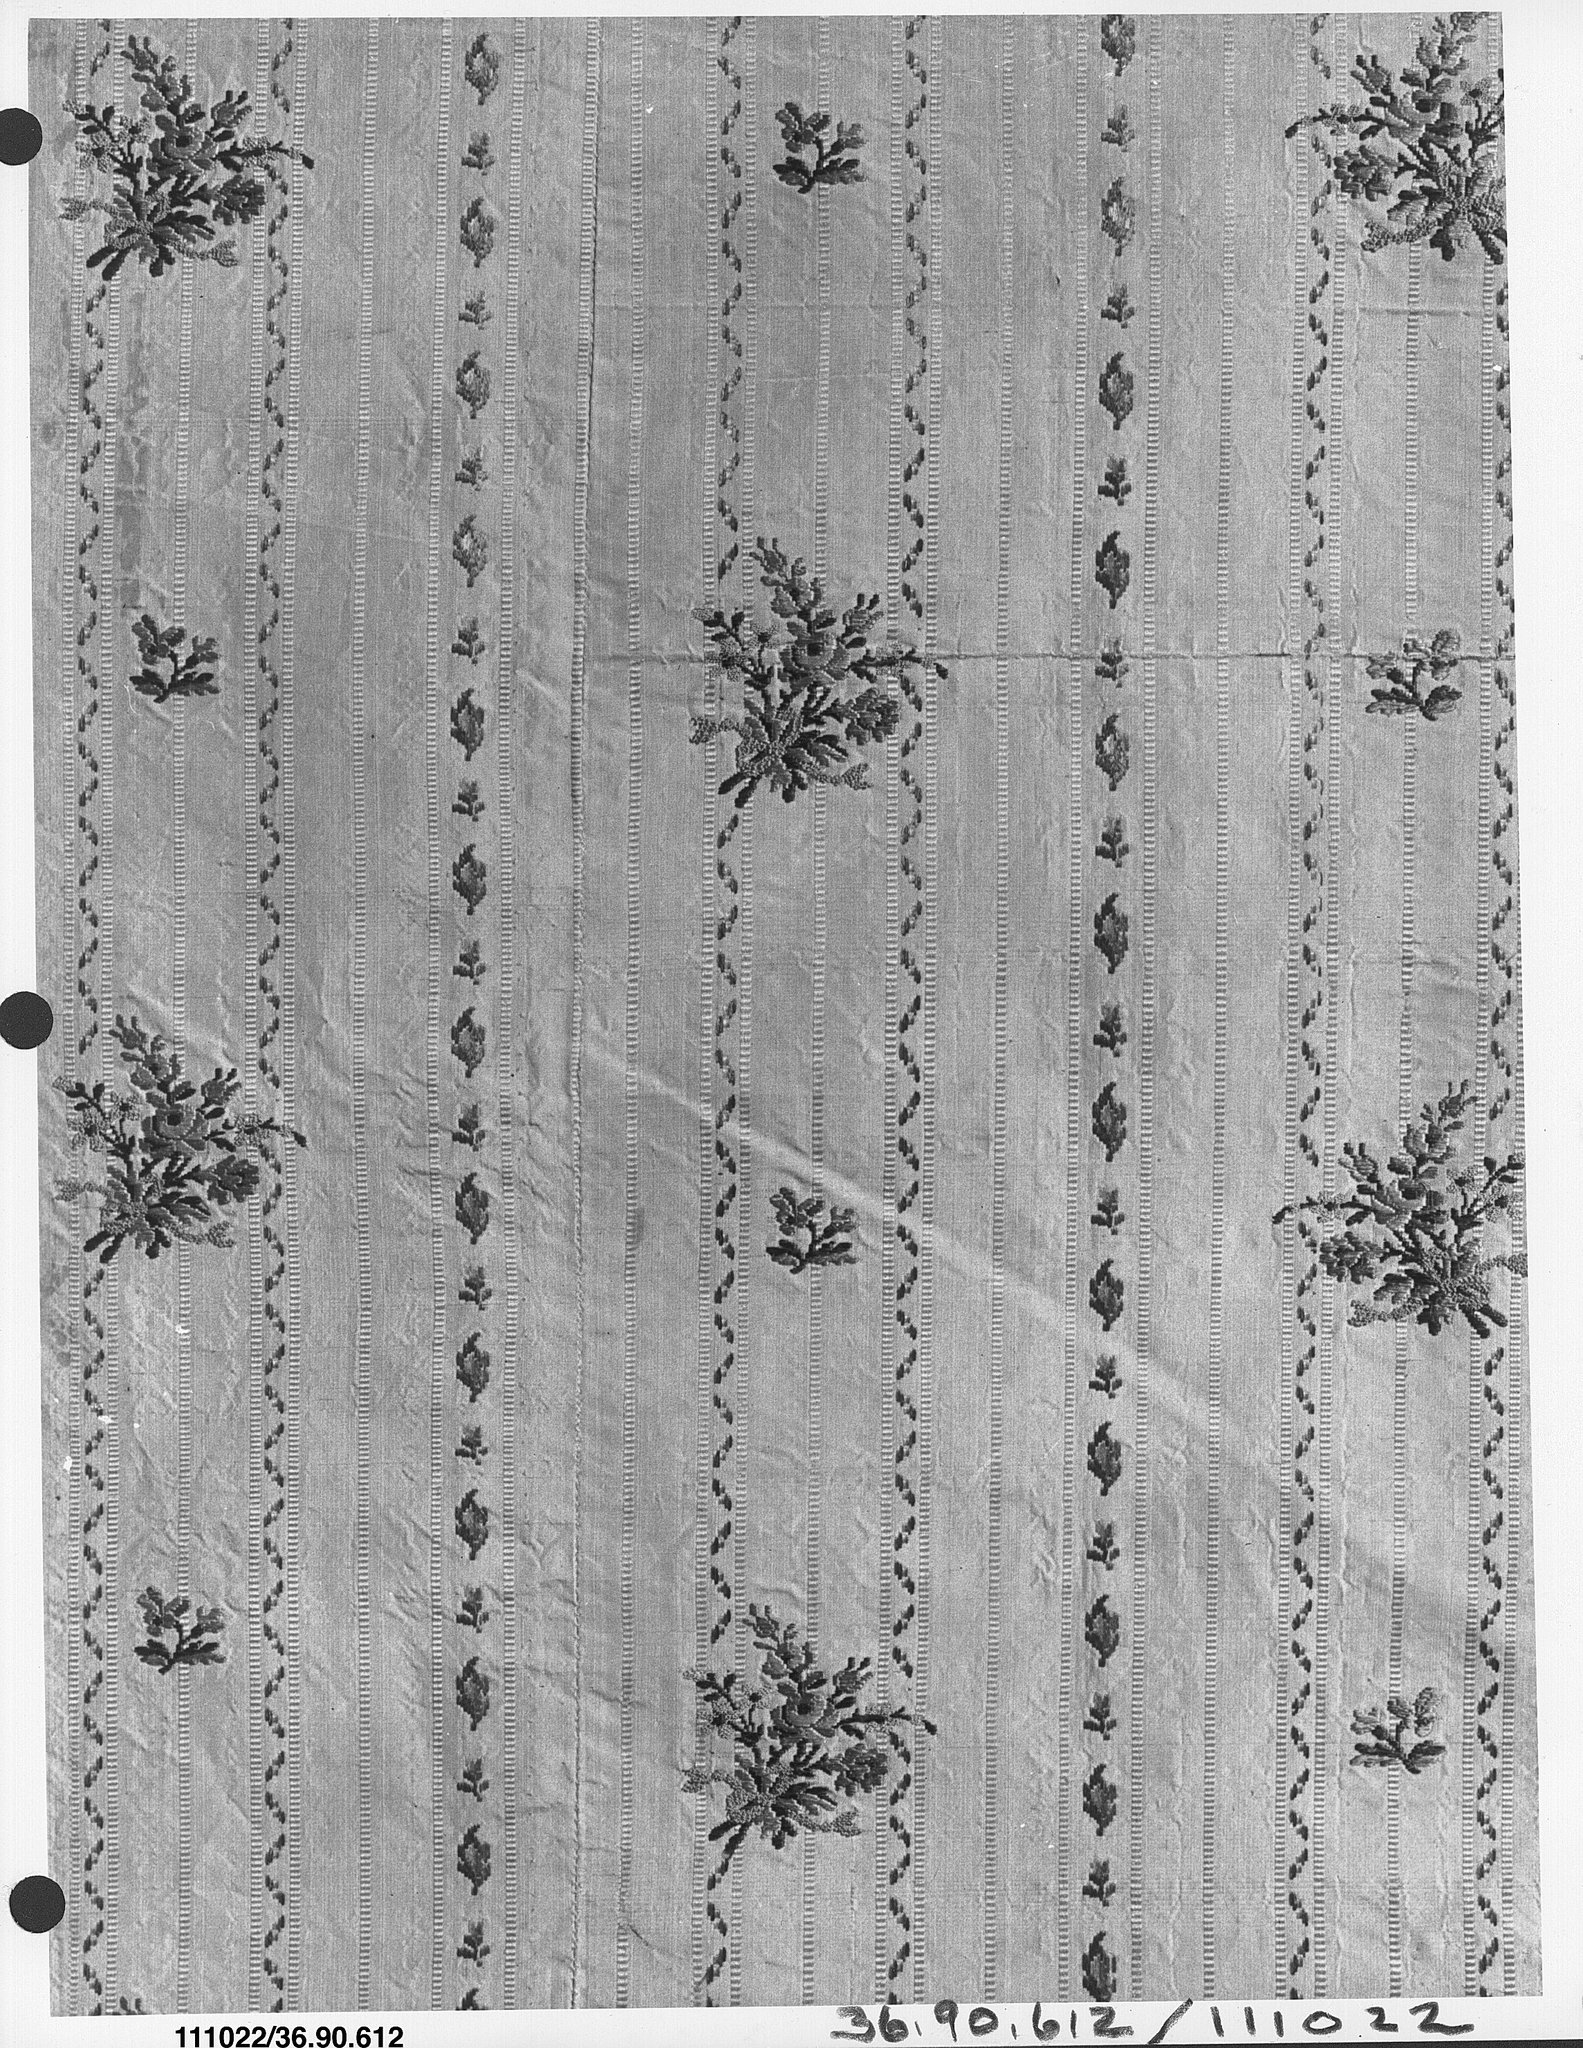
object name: piece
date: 1767-1800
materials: silk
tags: flowers,leaves